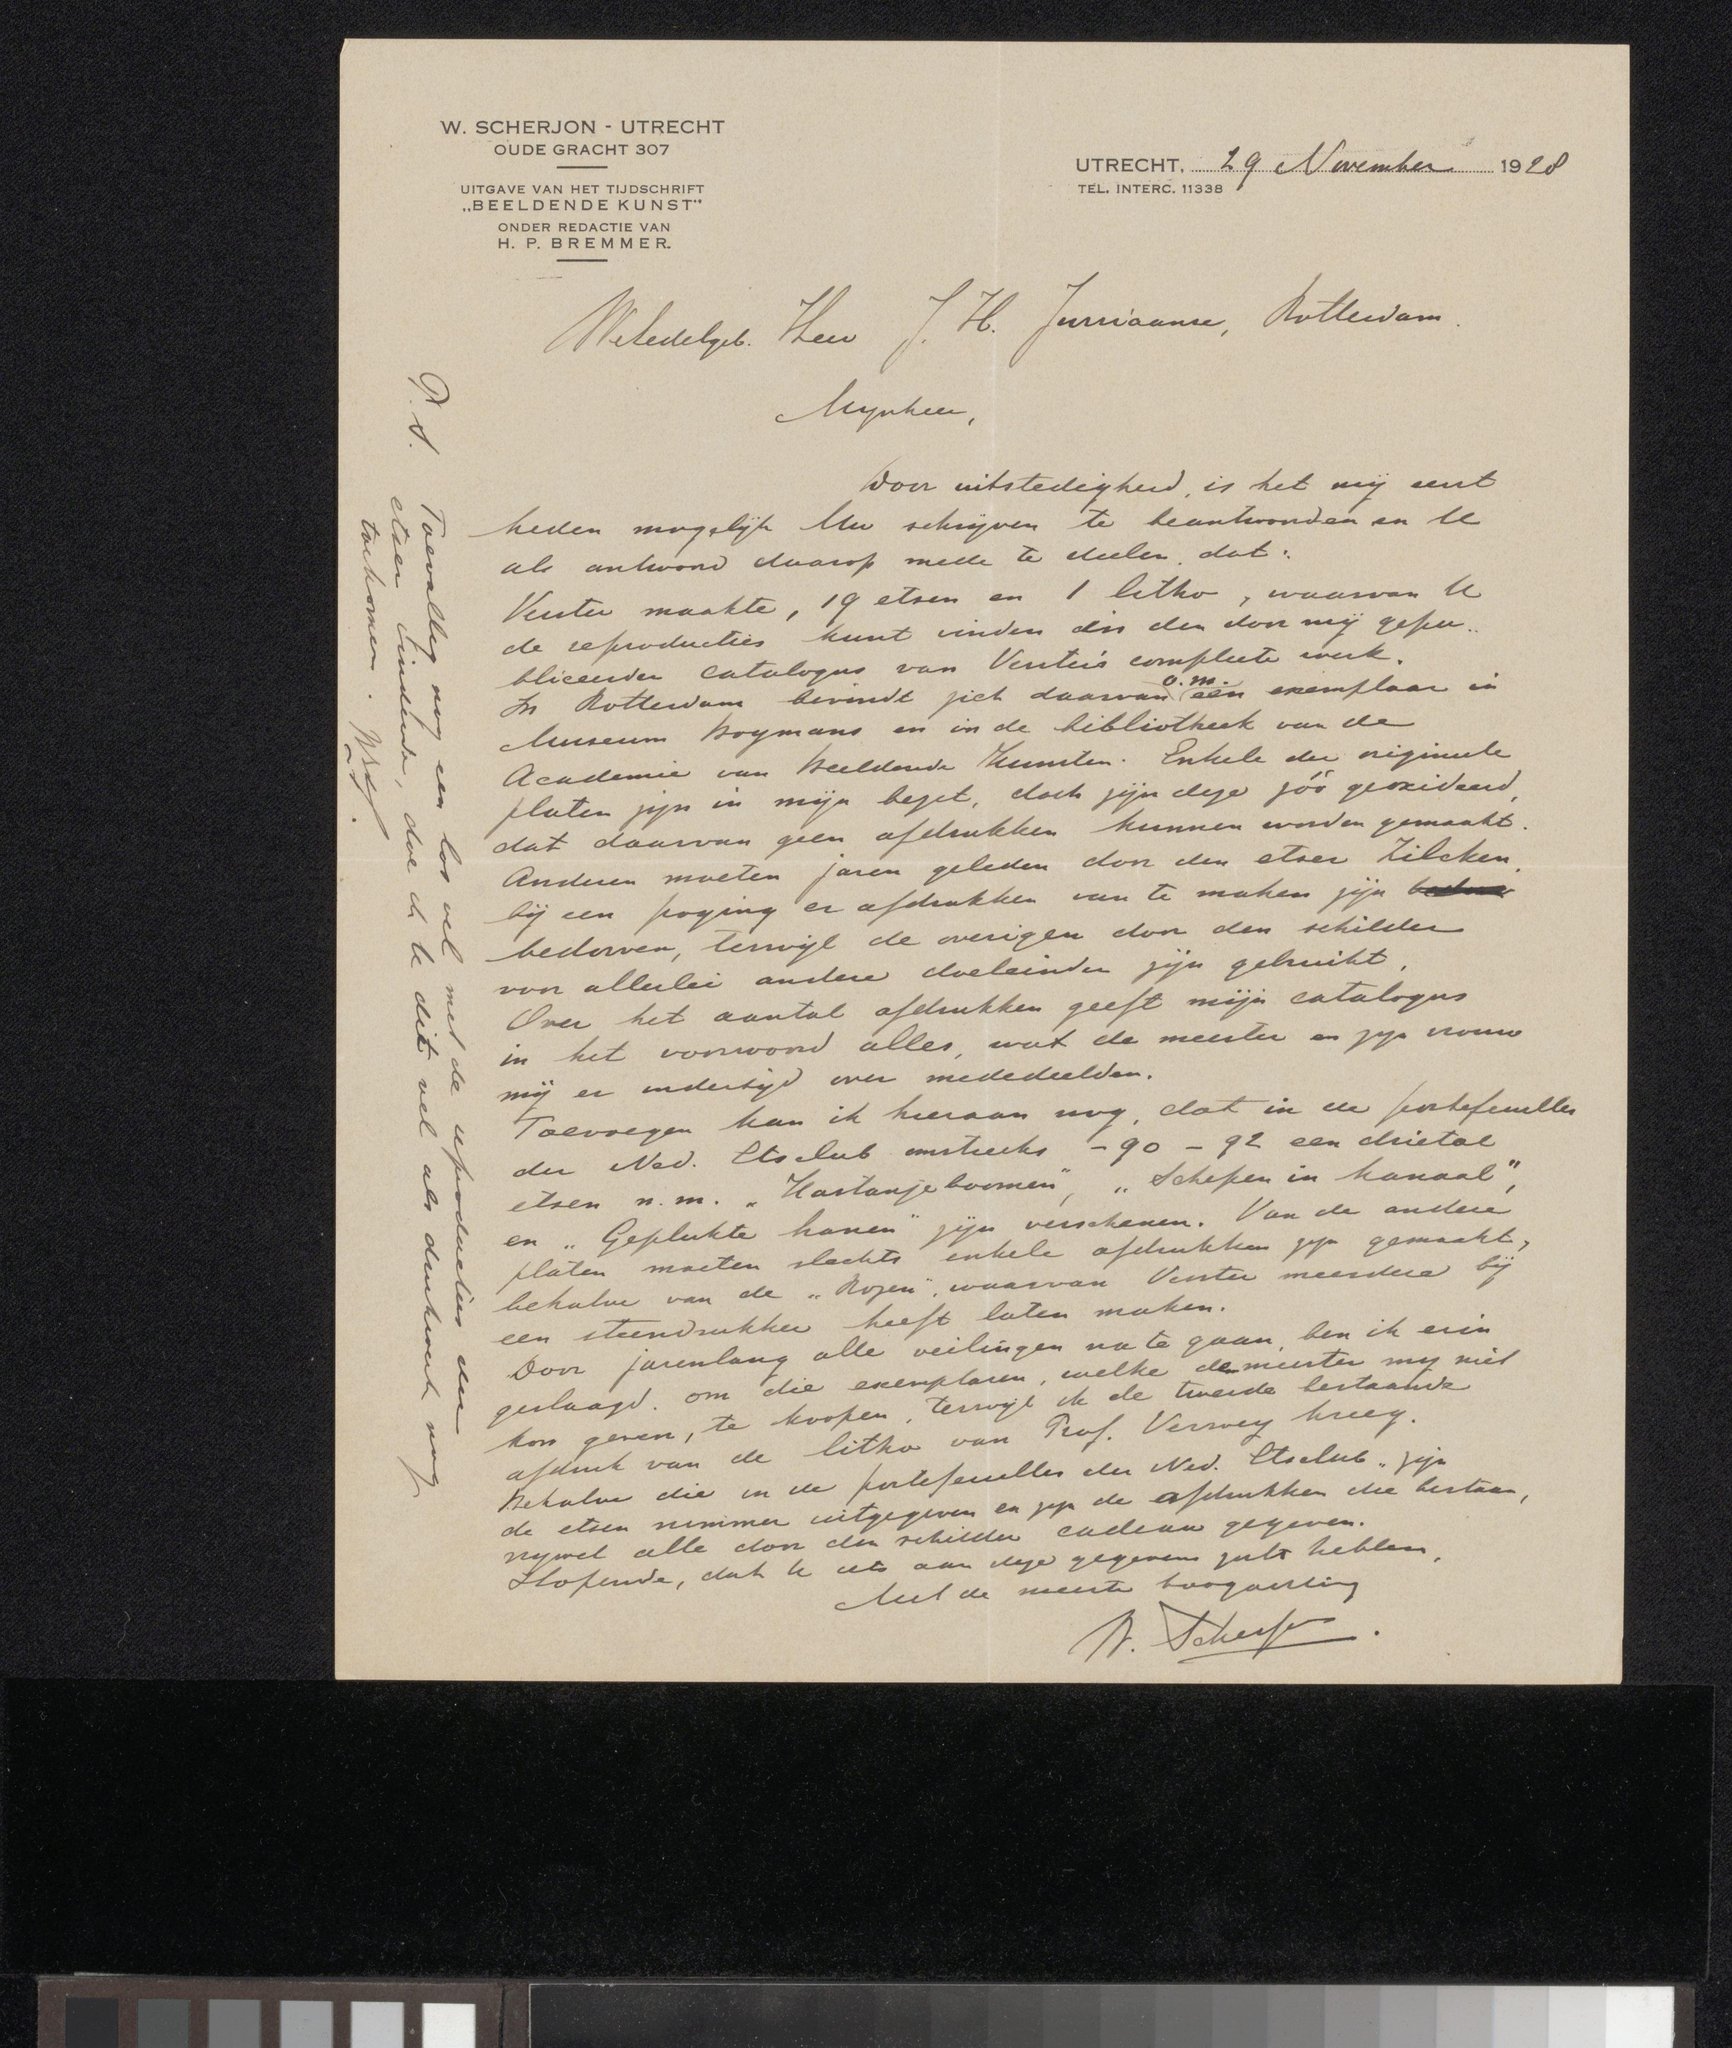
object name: letter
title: Brief aan Jan Hendrik Jurriaanse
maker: willem scherjon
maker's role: draughtsman, publisher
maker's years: 1878-1939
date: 1928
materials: ink, paper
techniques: pen, printing, writing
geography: utrecht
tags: leiden, floris verster, painter, draughtsman, philip zilcken, the graphic arts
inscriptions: collector's mark: ‘RPK’